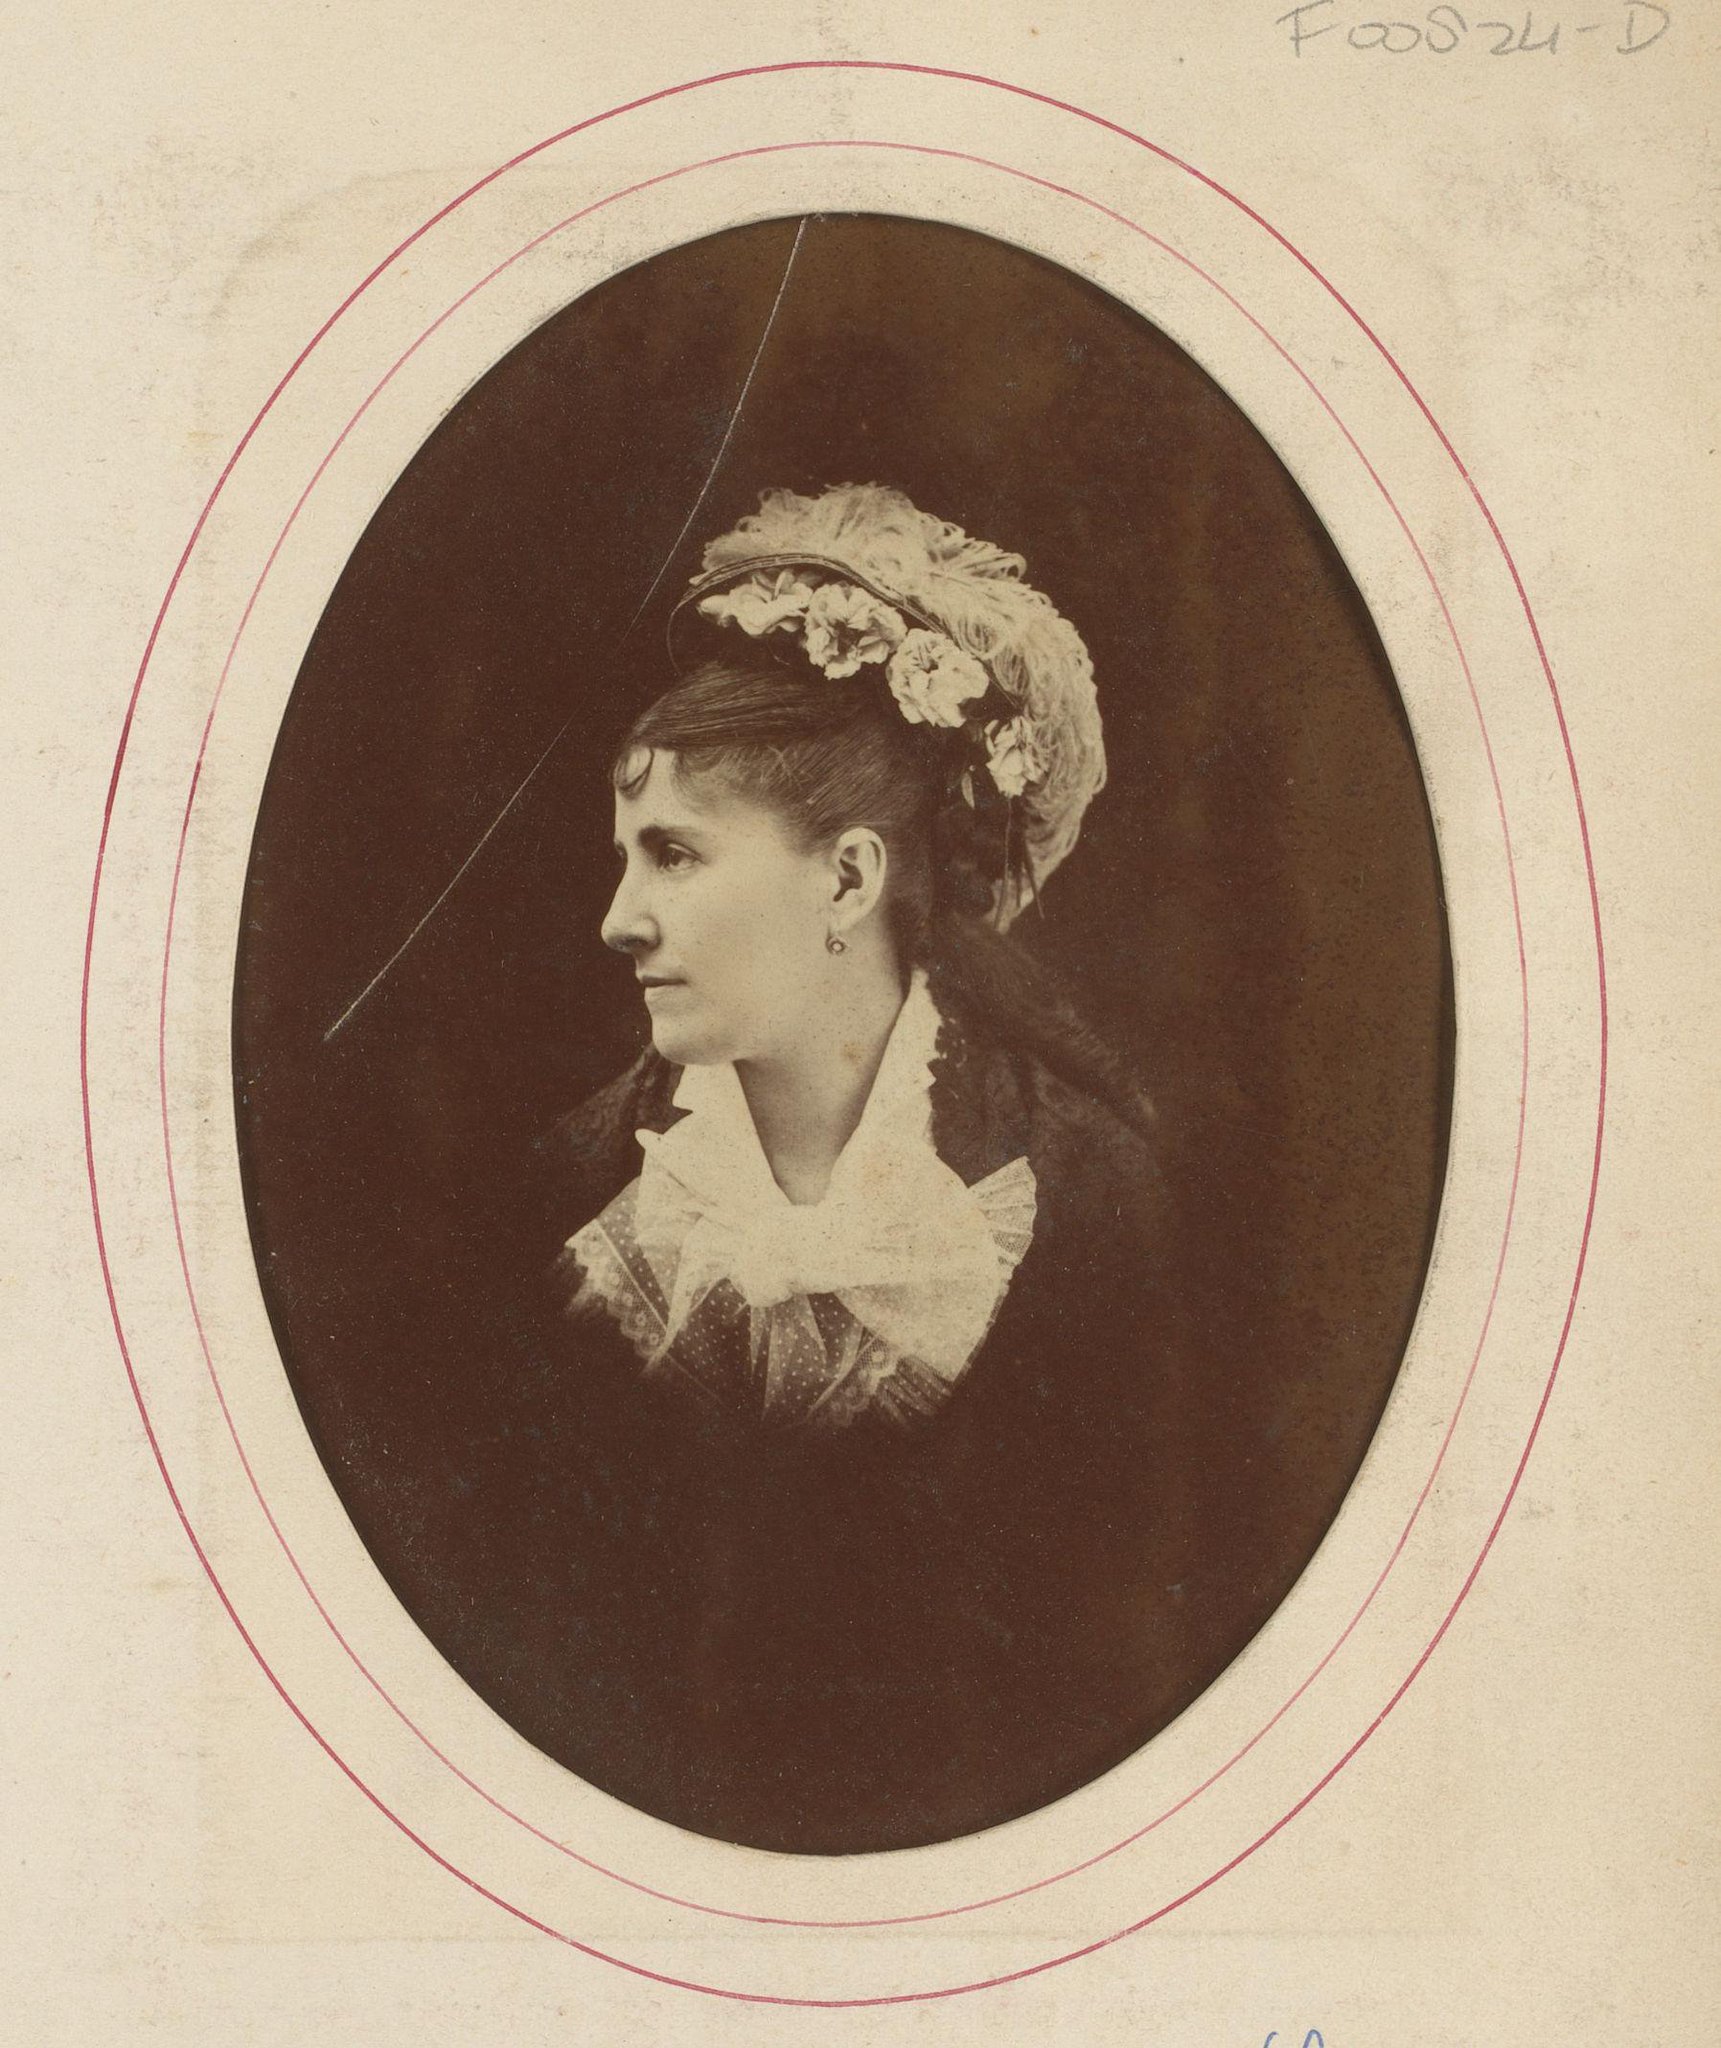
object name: album leaf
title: Portret van een vrouw, aangeduid als Mme. Alexandre Maréchal nee Le Quentrec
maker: louis martin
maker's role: fotograaf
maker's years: -1925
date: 1870-1900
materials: cardboard, paper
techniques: albumen print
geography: nantes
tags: adult woman, anonymous historical person portrayed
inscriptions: address: ‘12 Rue Boileau/ Nantes’